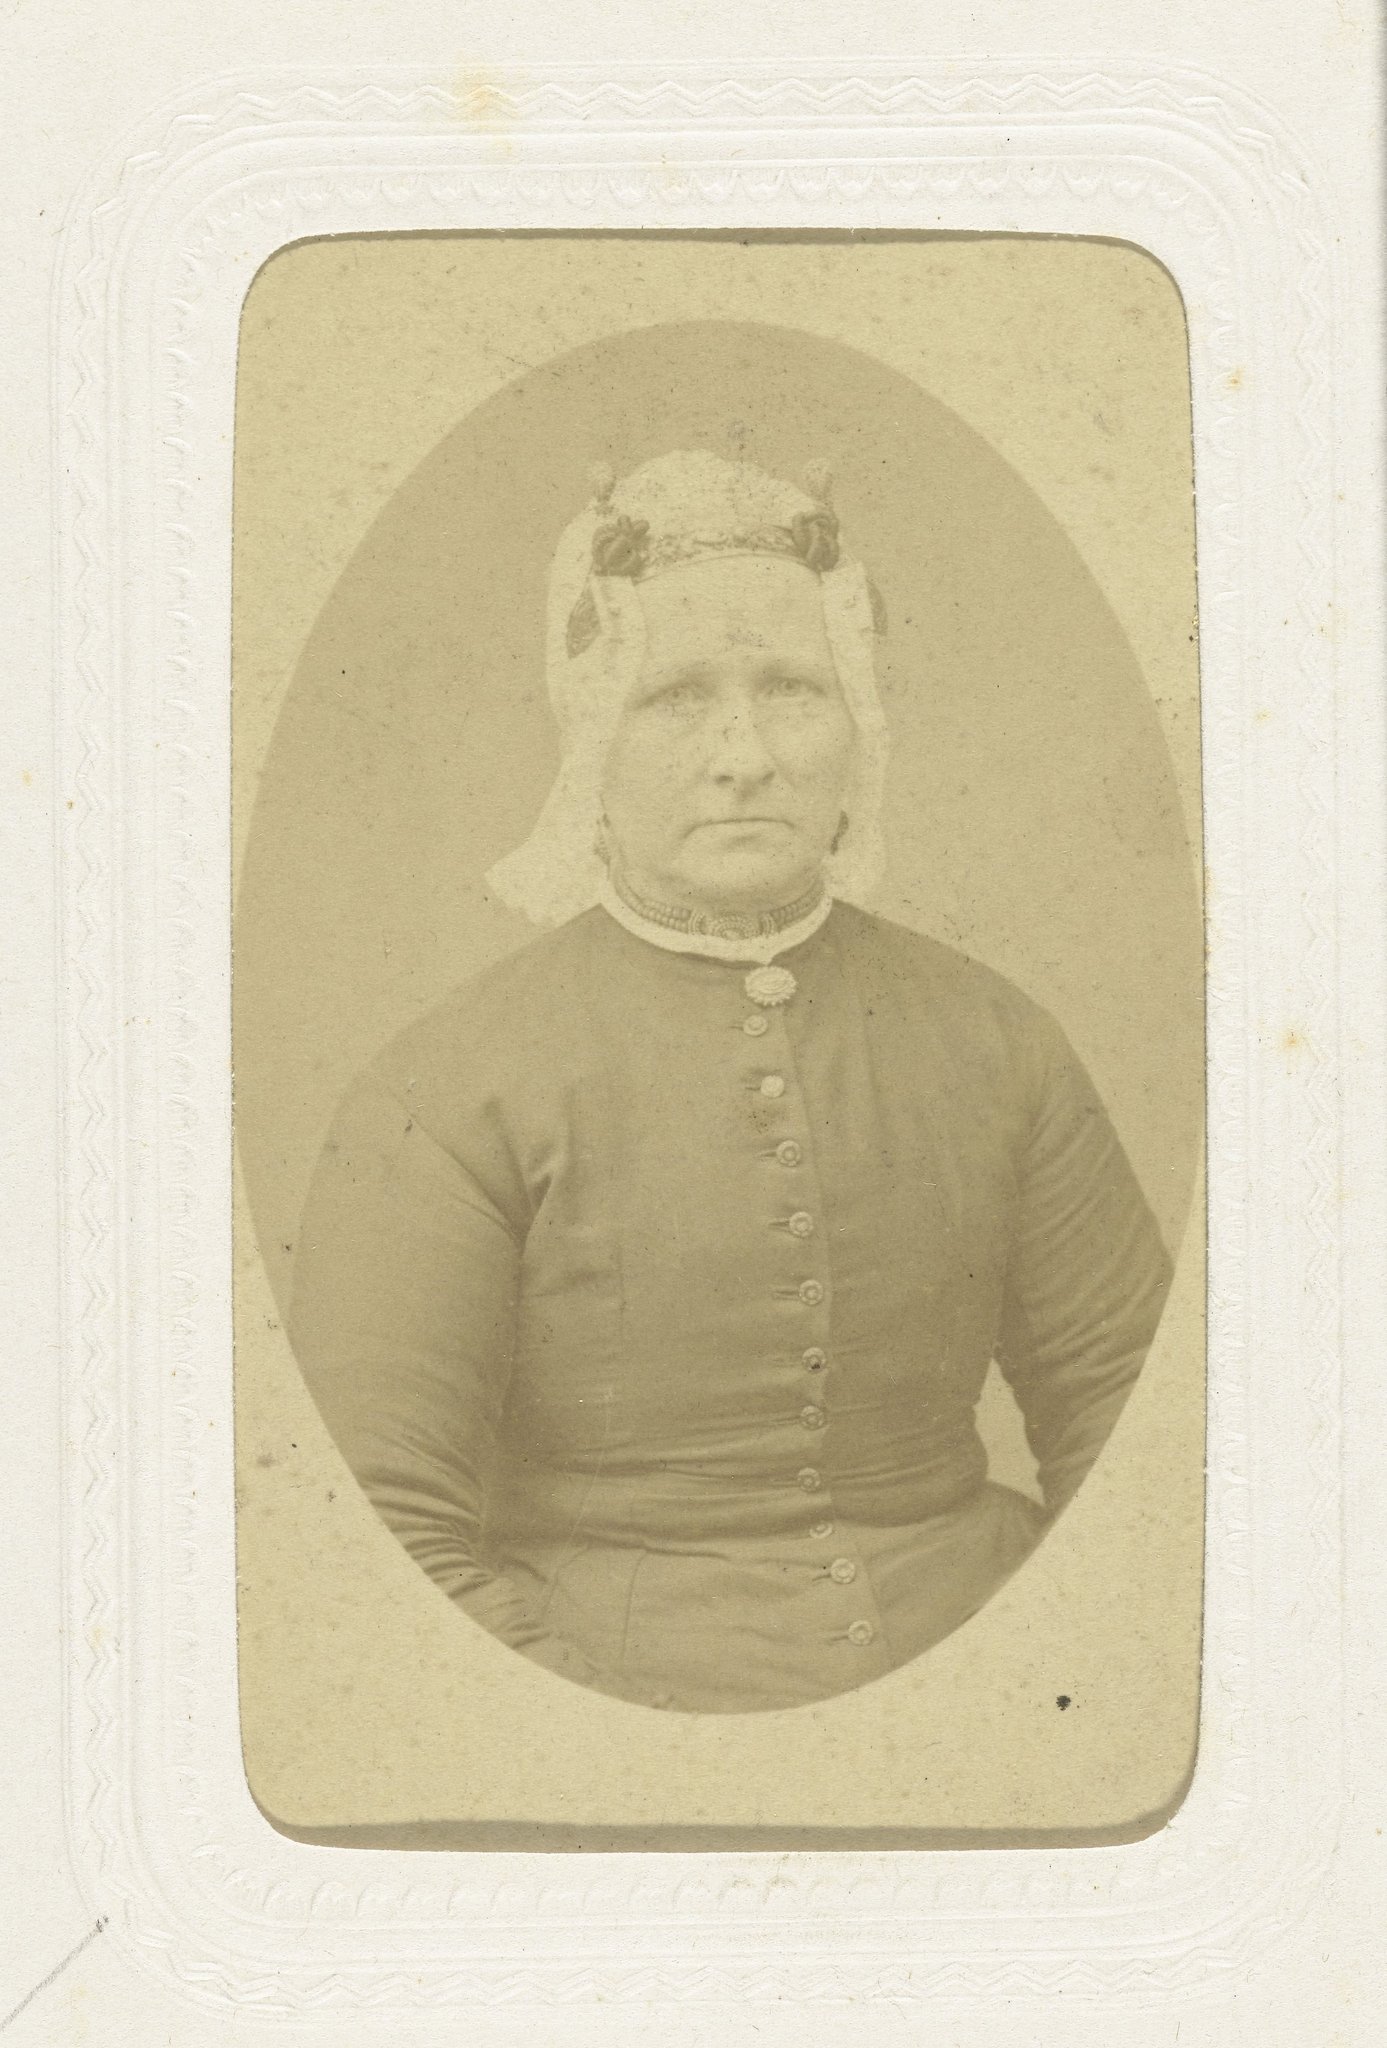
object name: carte de visite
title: Studioportret van een vrouw in Noord-Hollandse klederdracht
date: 1863-1866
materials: cardboard, paper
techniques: albumen print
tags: folk costume, regional costume